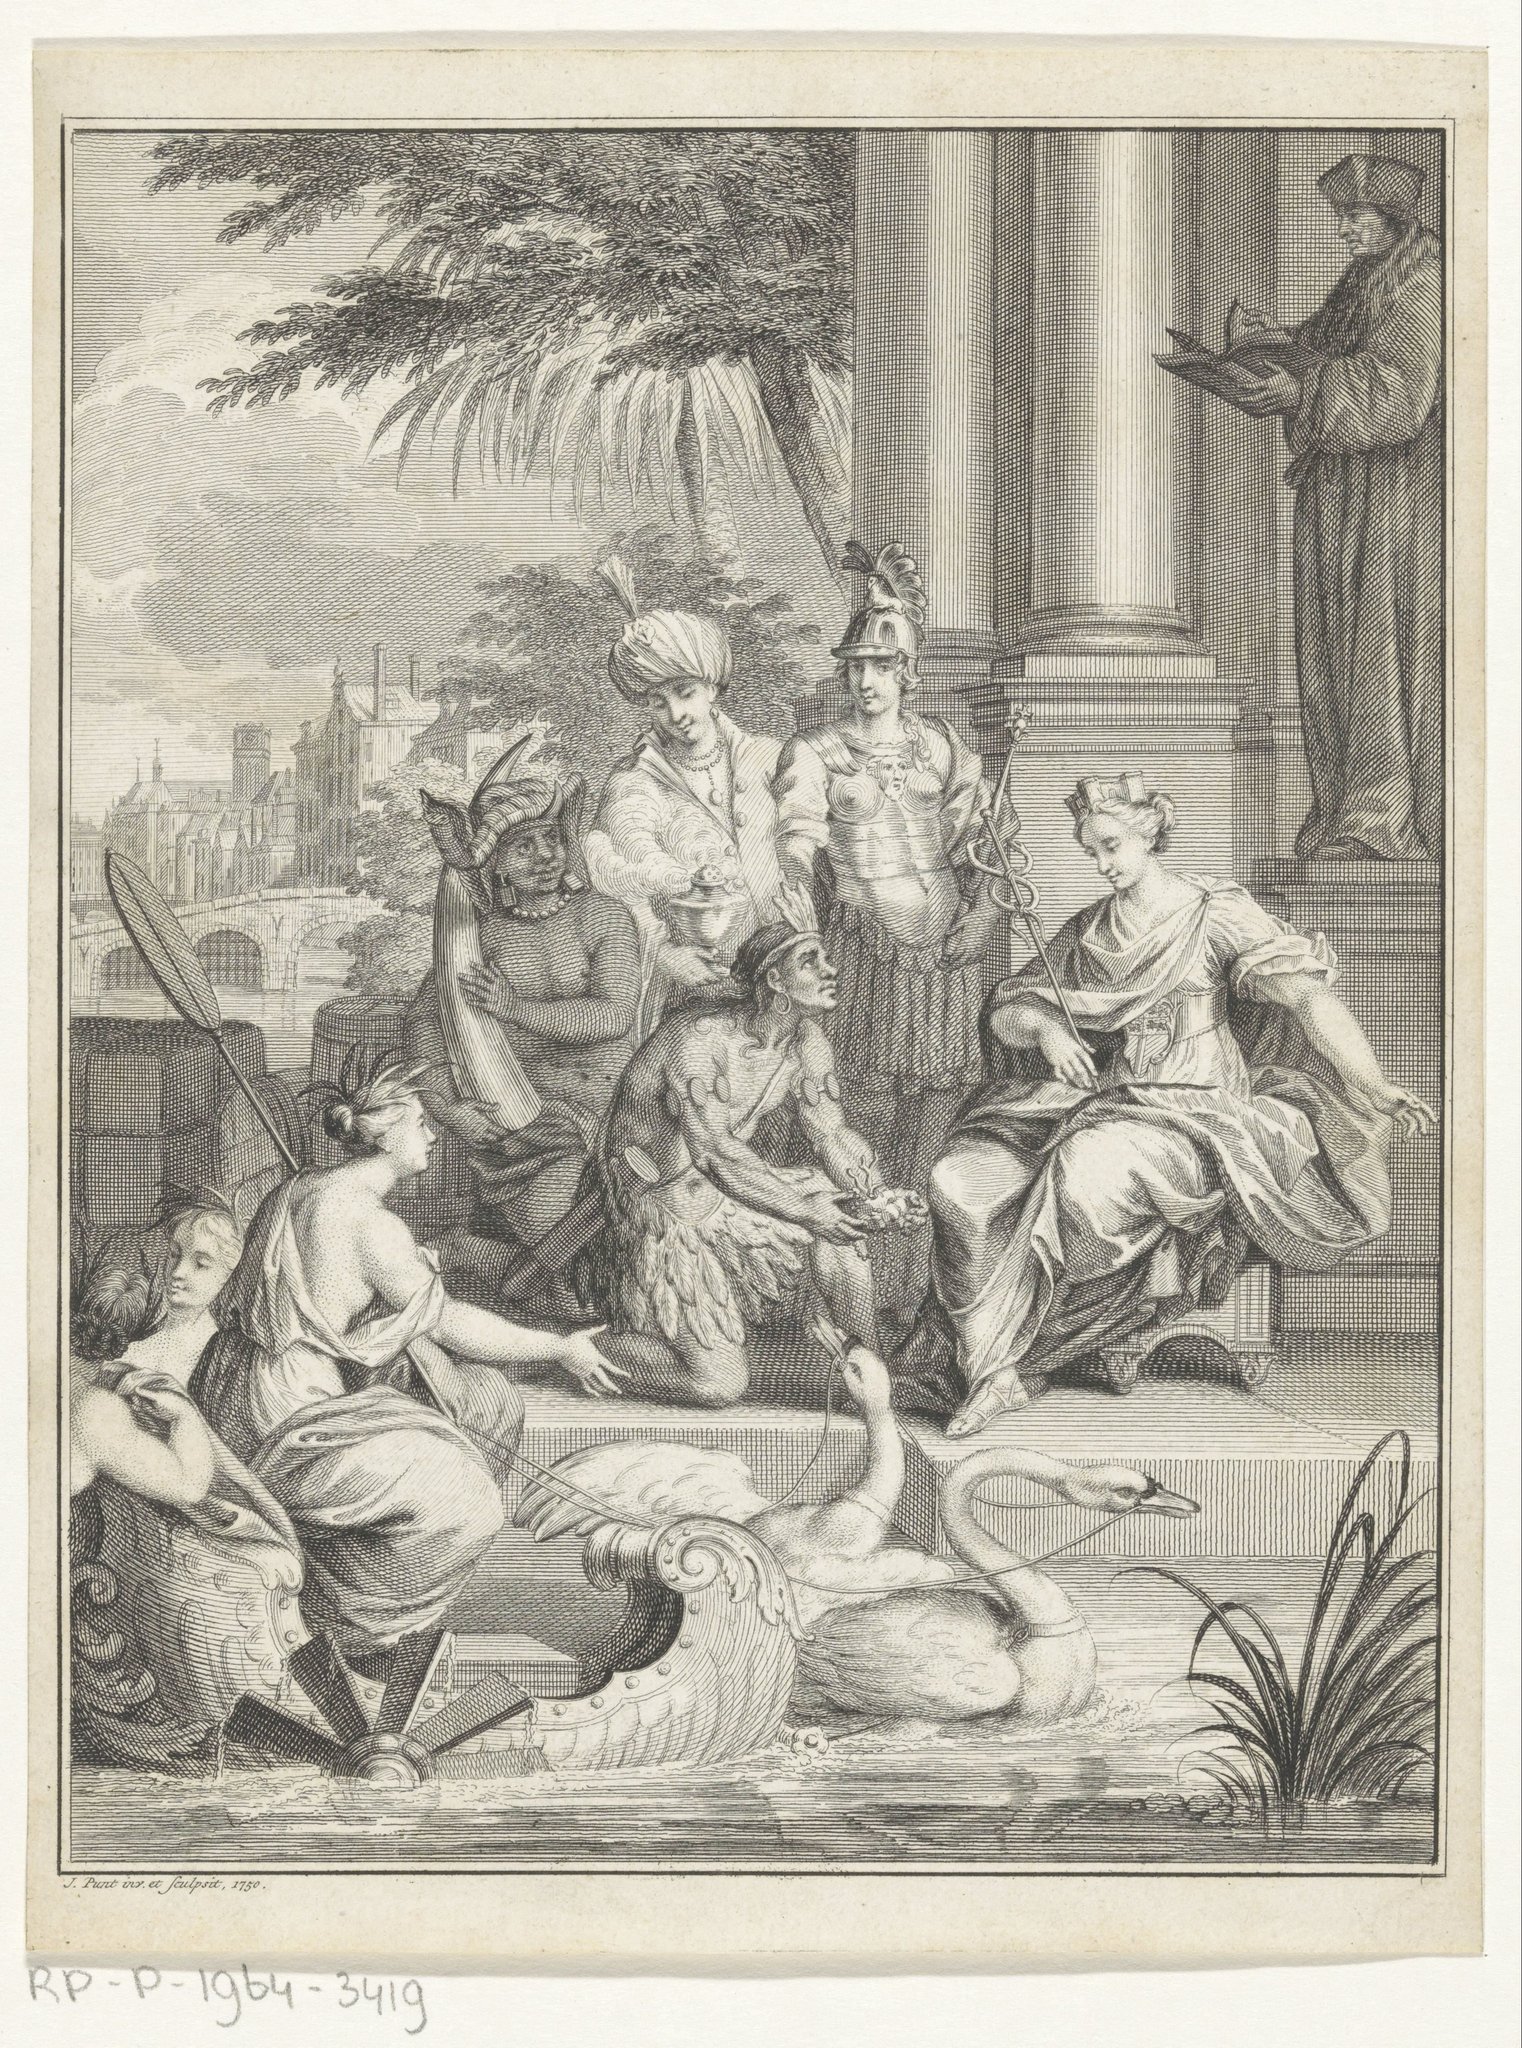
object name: book illustration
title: Allegorie op de Rotterdamse Handel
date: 1750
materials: paper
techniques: engraving, etching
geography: rotterdam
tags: desiderius erasmus, europeans, asiatic races and peoples, europe represented allegorically; 'europa' (ripa), asia represented allegorically; 'asia' (ripa), africa represented allegorically; 'africa' (ripa), america represented allegorically; 'america' (ripa), africans, native peoples of the americas, personifications of countries, nations, states, districts, etc. (+ nation; national), rotterdam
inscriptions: collector's mark: Lugt 2228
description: Personificaties van de vier werelddelen – Amerika met verentooi en -rok, Afrika met olifantenhoed en slagtand, Azië met tulband en wierrookvat en Europa met harnas en scepter – bieden de stedenmaagd van Rotterdam geschenken aan. Achter haar een standbeeld van Erasmus. Op de voorgrond een nimf op een wagen, voortgetrokken door zwanen op de rivier. Op de achtergrond een stadsgezicht met de Sint-Laurenskerk.